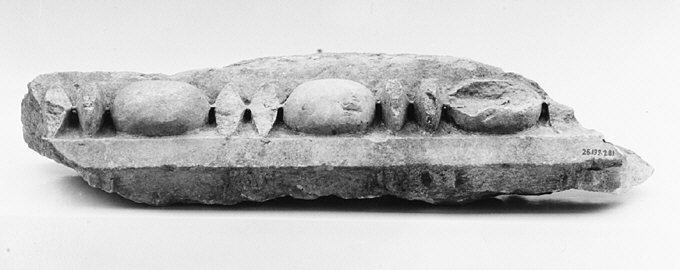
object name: architectural fragment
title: Marble architectural fragment from the Temple of Artemis at Sardis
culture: greek or roman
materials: marble